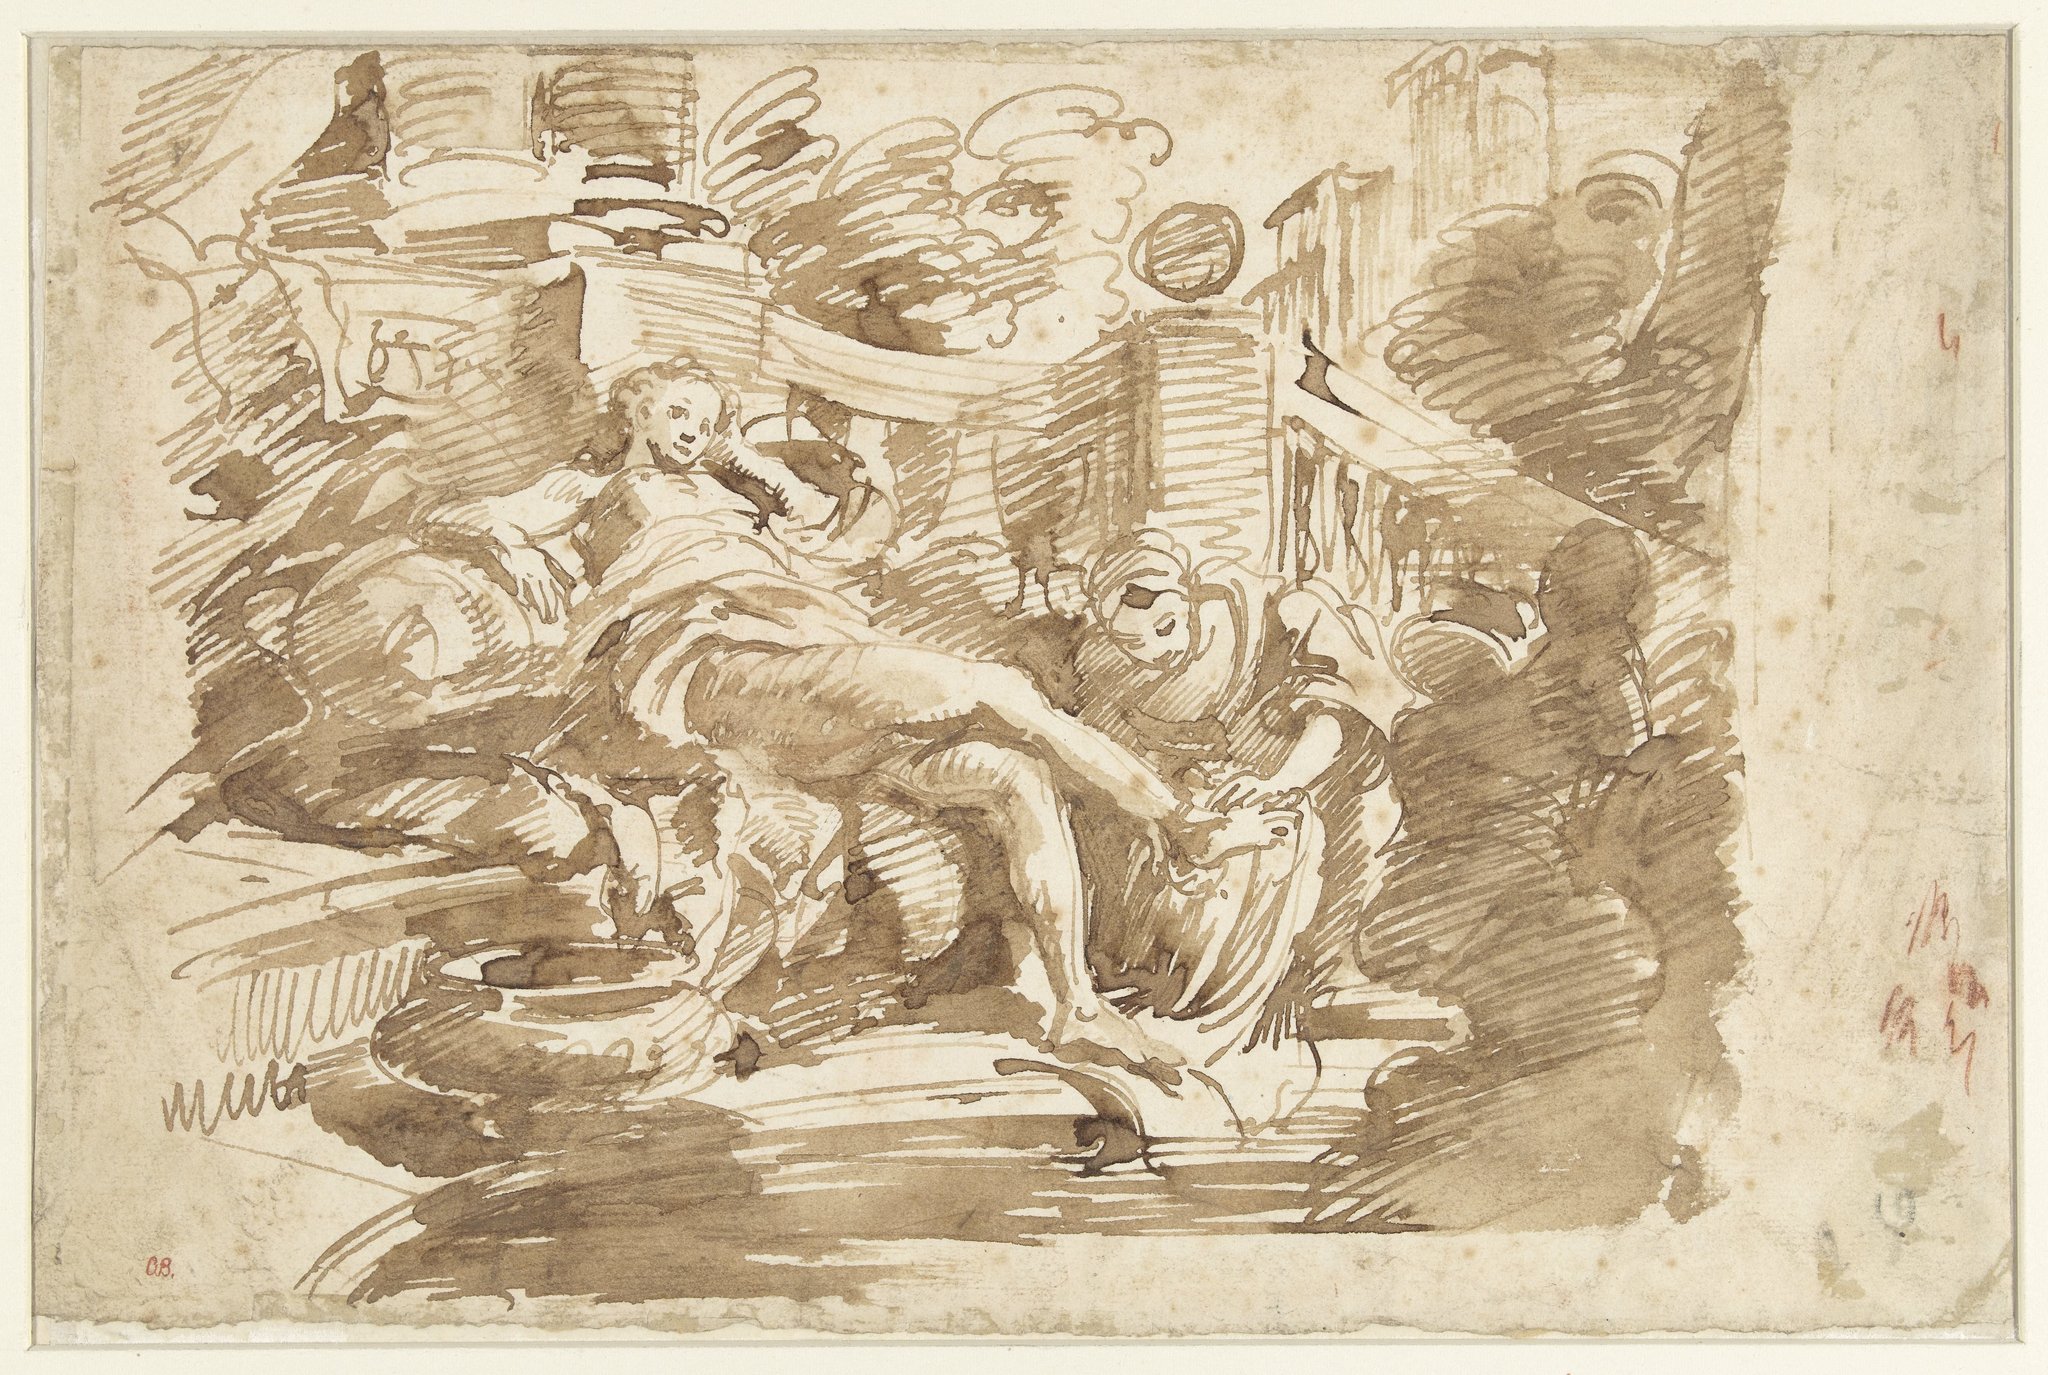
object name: drawing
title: Bathsheba at Her Bath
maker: Anonymous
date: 1729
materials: paper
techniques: brush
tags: bathsheba attended by servant(s)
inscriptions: collector's mark, recto, lower left: Lugt 494a, collector's mark, verso, lower centre: Lugt 2228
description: Batseba (?): jonge, halfnaakte vrouw, in een paleistuin achterover liggend, laat zich door een dienares de voeten wassen.